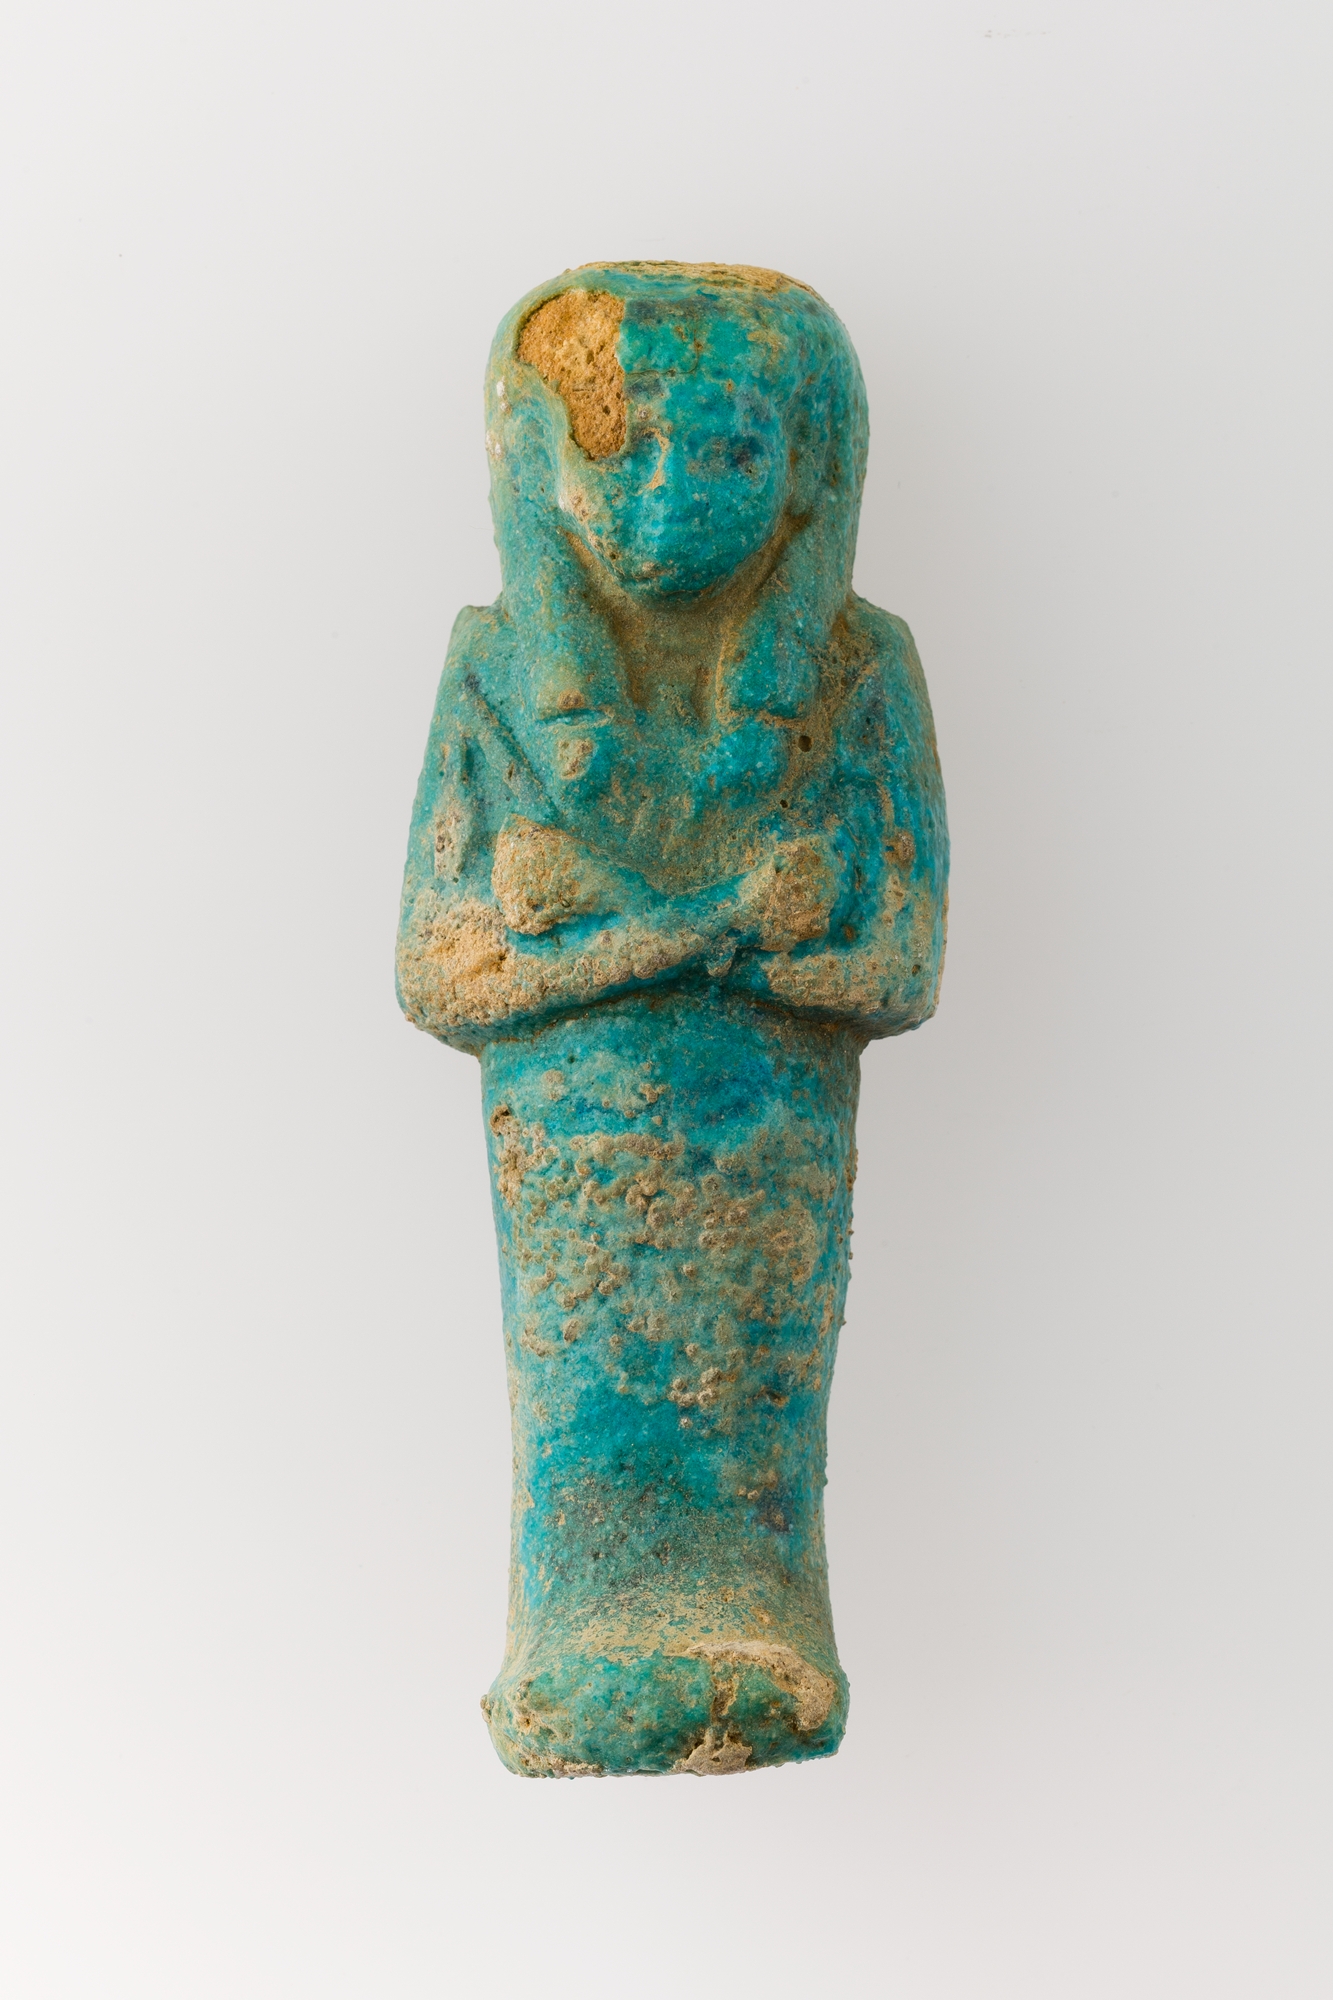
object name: shabti, henettawy c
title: Worker Shabti of Henettawy (C), Daughter of Isetemkheb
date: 990-970 BCE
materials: faience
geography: egypt